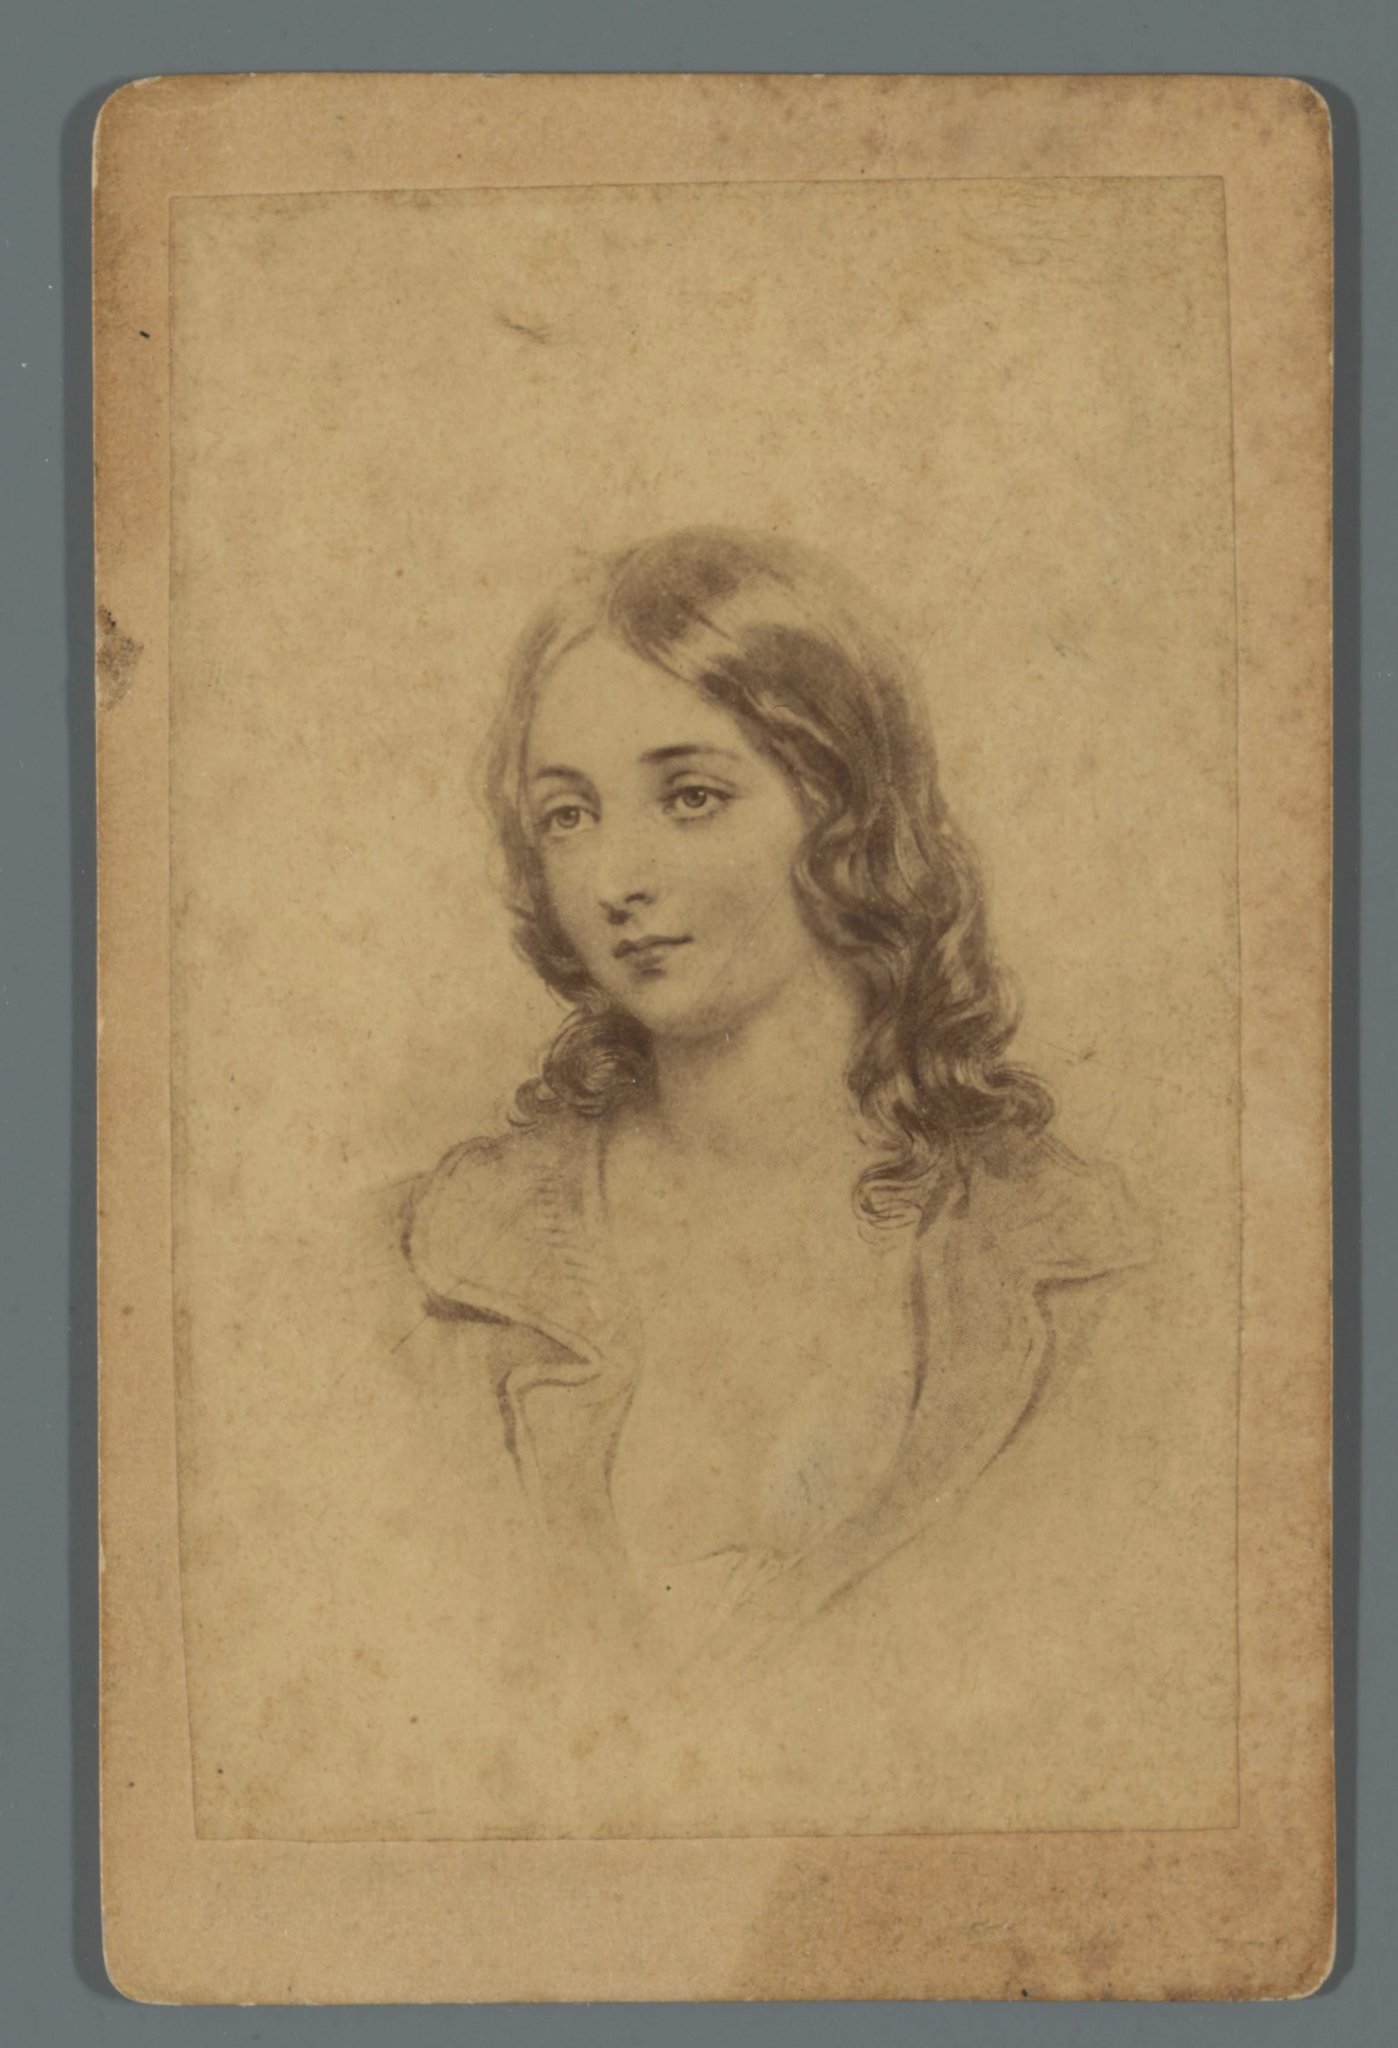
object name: reproduction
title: Fotoreproductie van een tekening van een portret van een onbekende vrouw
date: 1850-1900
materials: cardboard, photographic support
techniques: albumen print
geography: the hague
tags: historical persons not known by name - bb - woman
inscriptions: name: ‘W. F. VAN WINSEN’, inscription: ‘383. Flower of Dumblan.’, address: ‘BOEKHANDEL/ van/ L. J. Verhoeven/ Spuistraat No. 36/ 's Hage.’